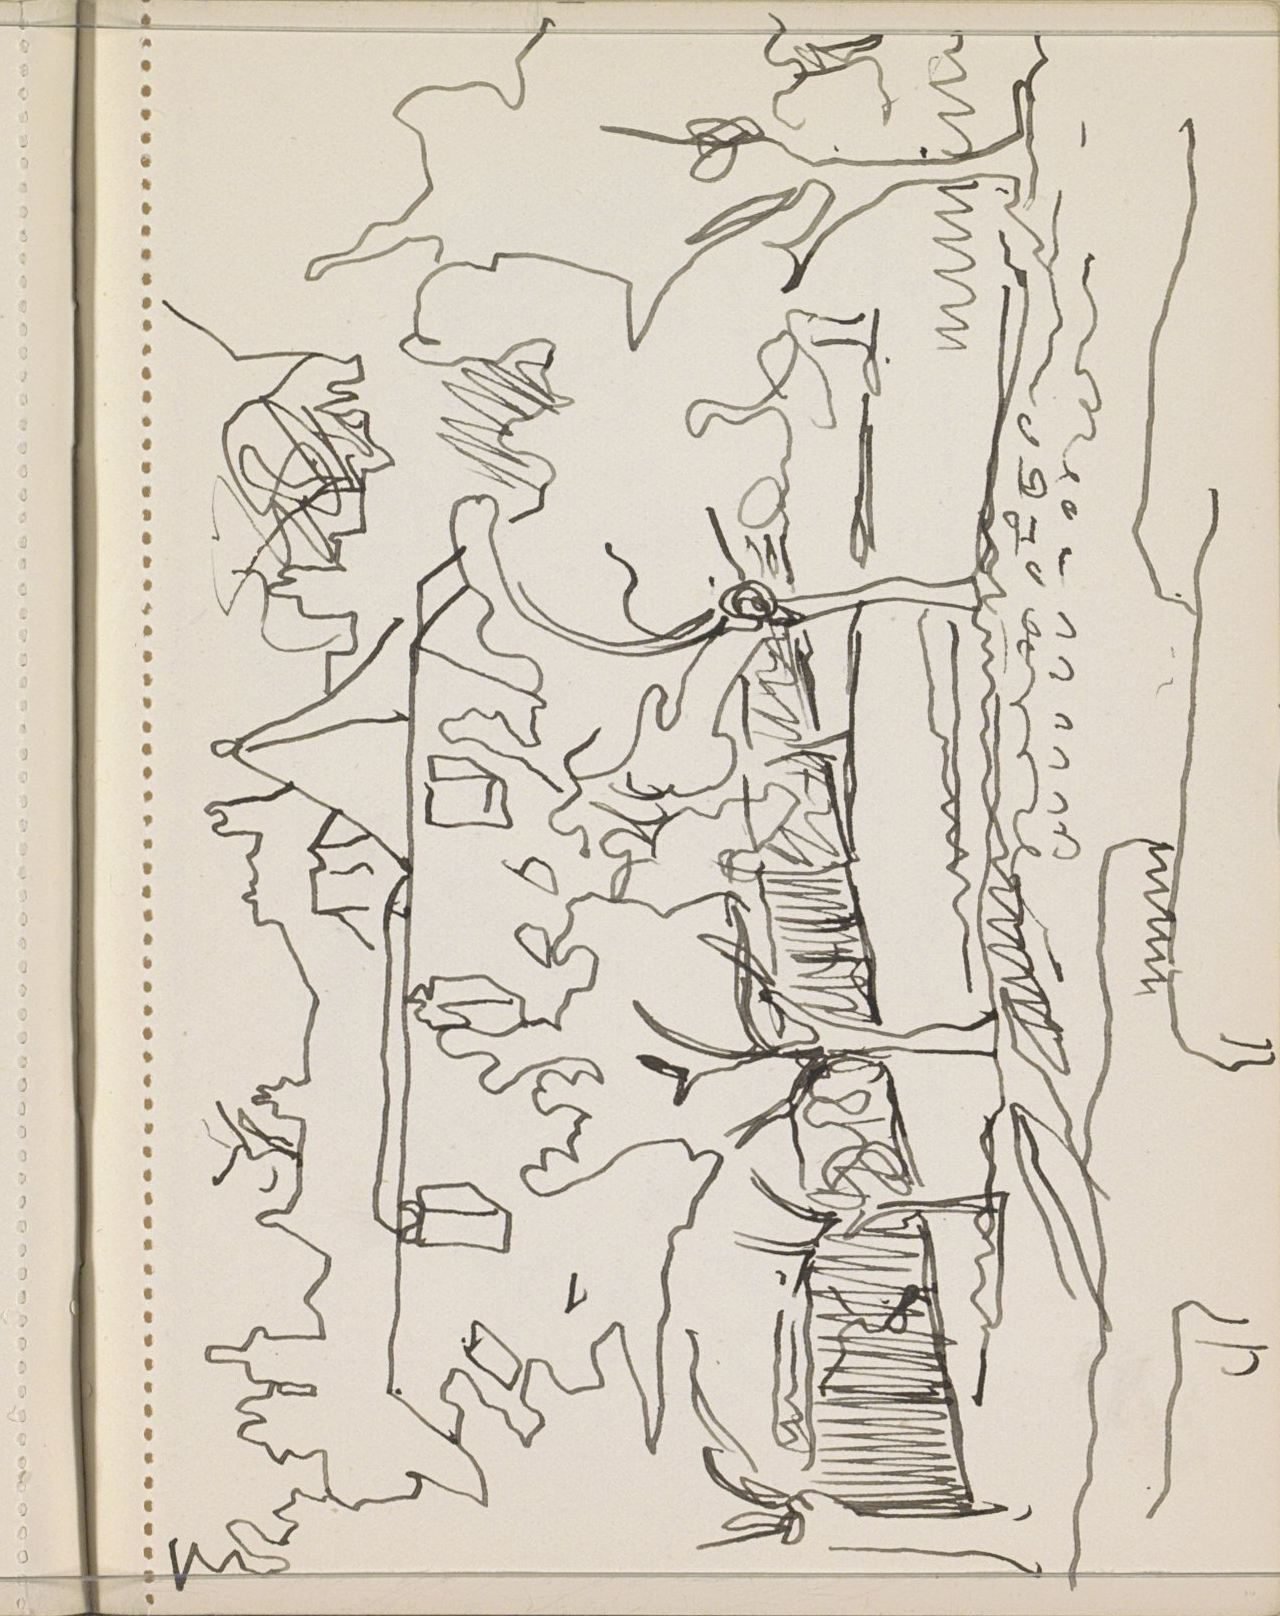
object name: sketchbook leaf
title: Huizen naast een boomgaard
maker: reijer stolk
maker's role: draughtsman, print maker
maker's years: 1896-1945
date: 1906-1945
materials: ink, paper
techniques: pen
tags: trees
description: Blad 38 recto uit een schetsboek met 42 bladen.